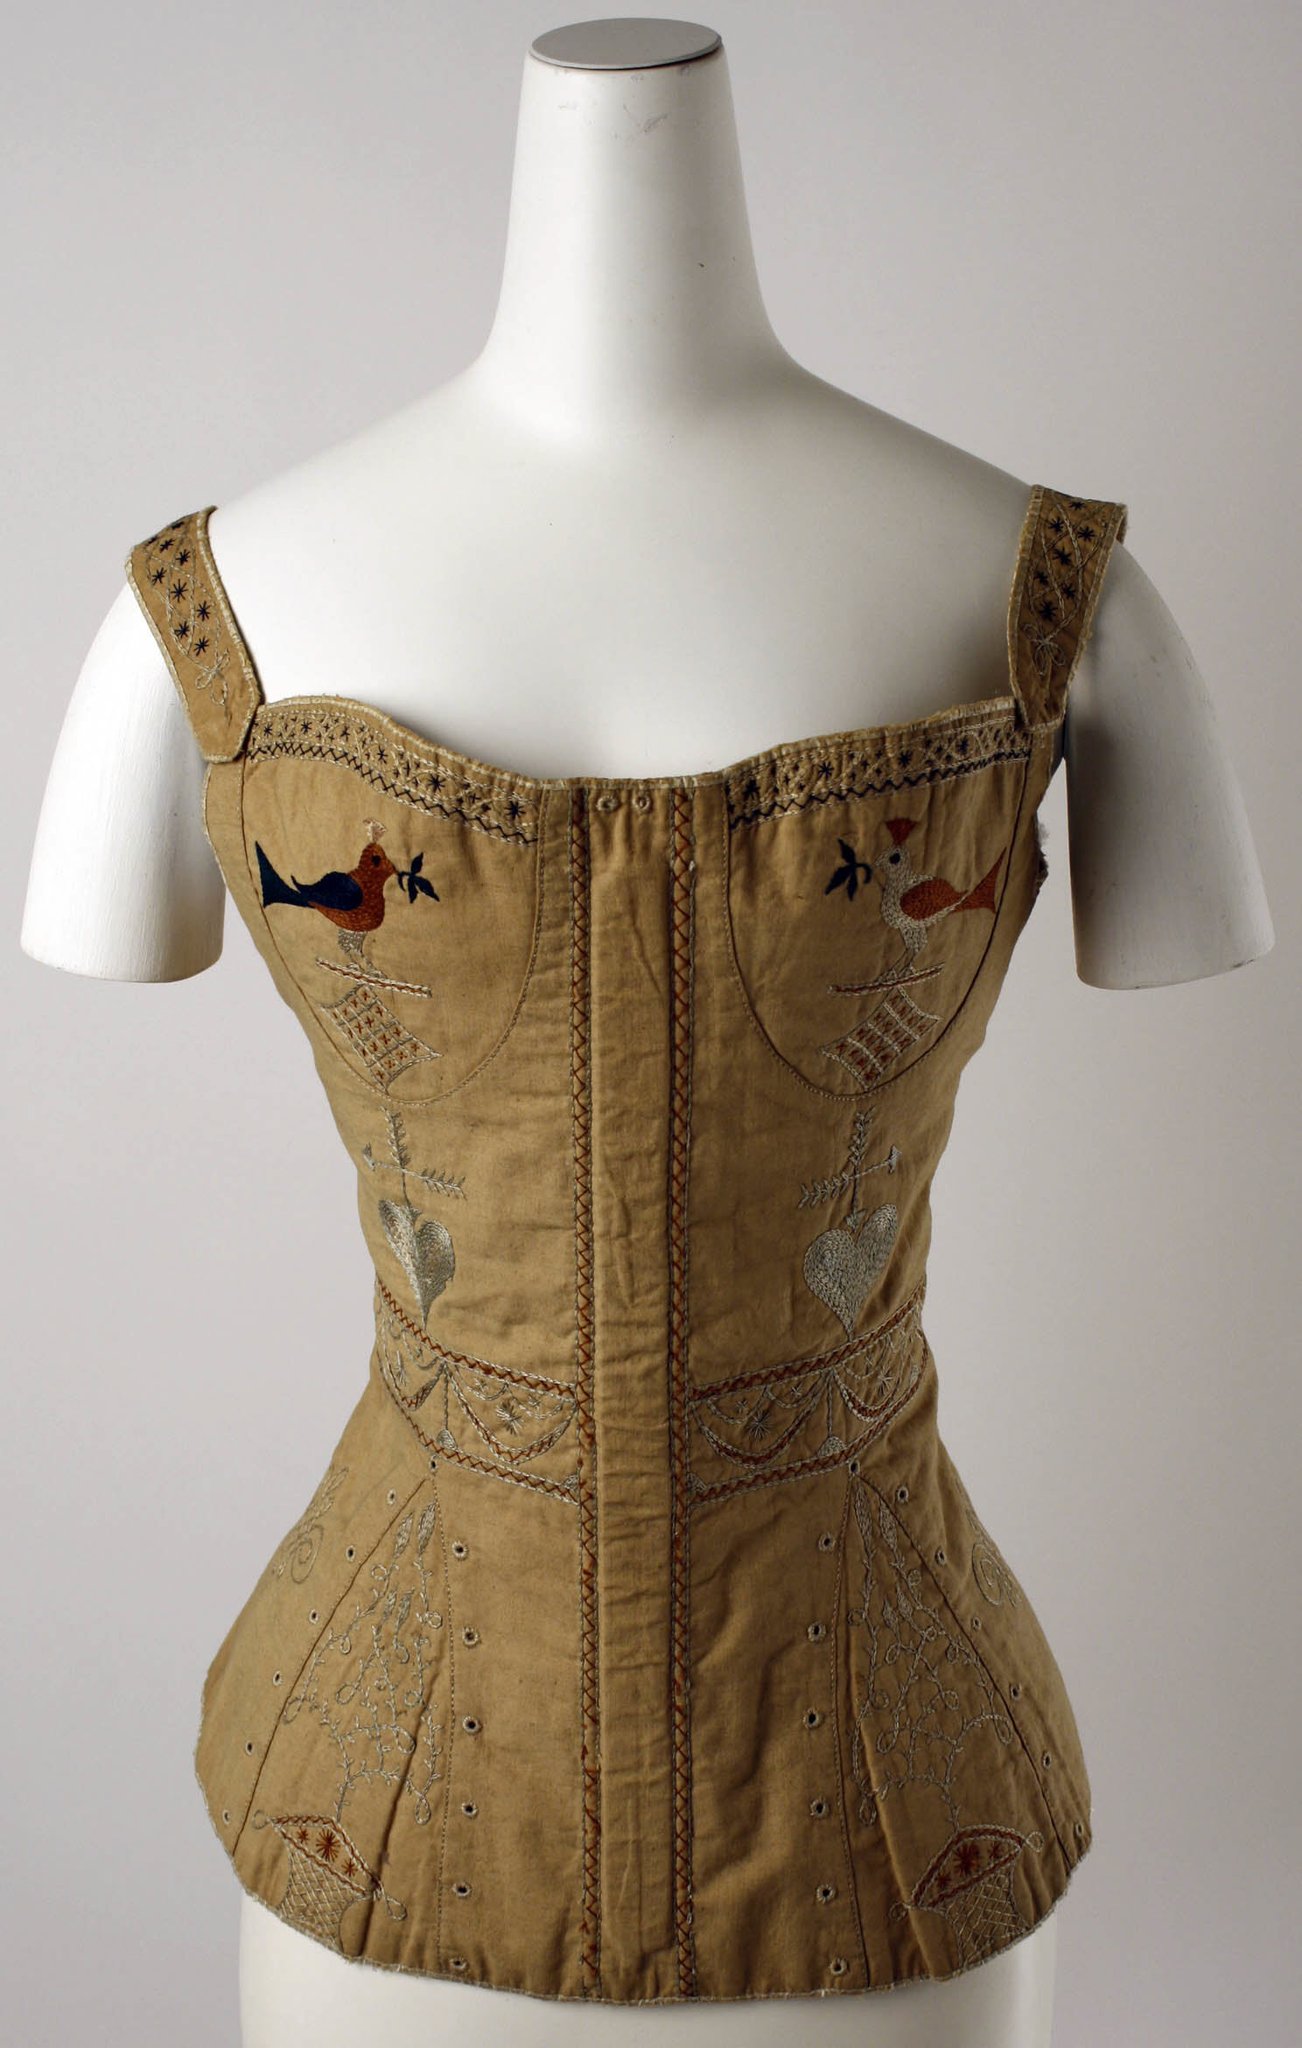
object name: corset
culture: american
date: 1820-1839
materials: cotton, silk